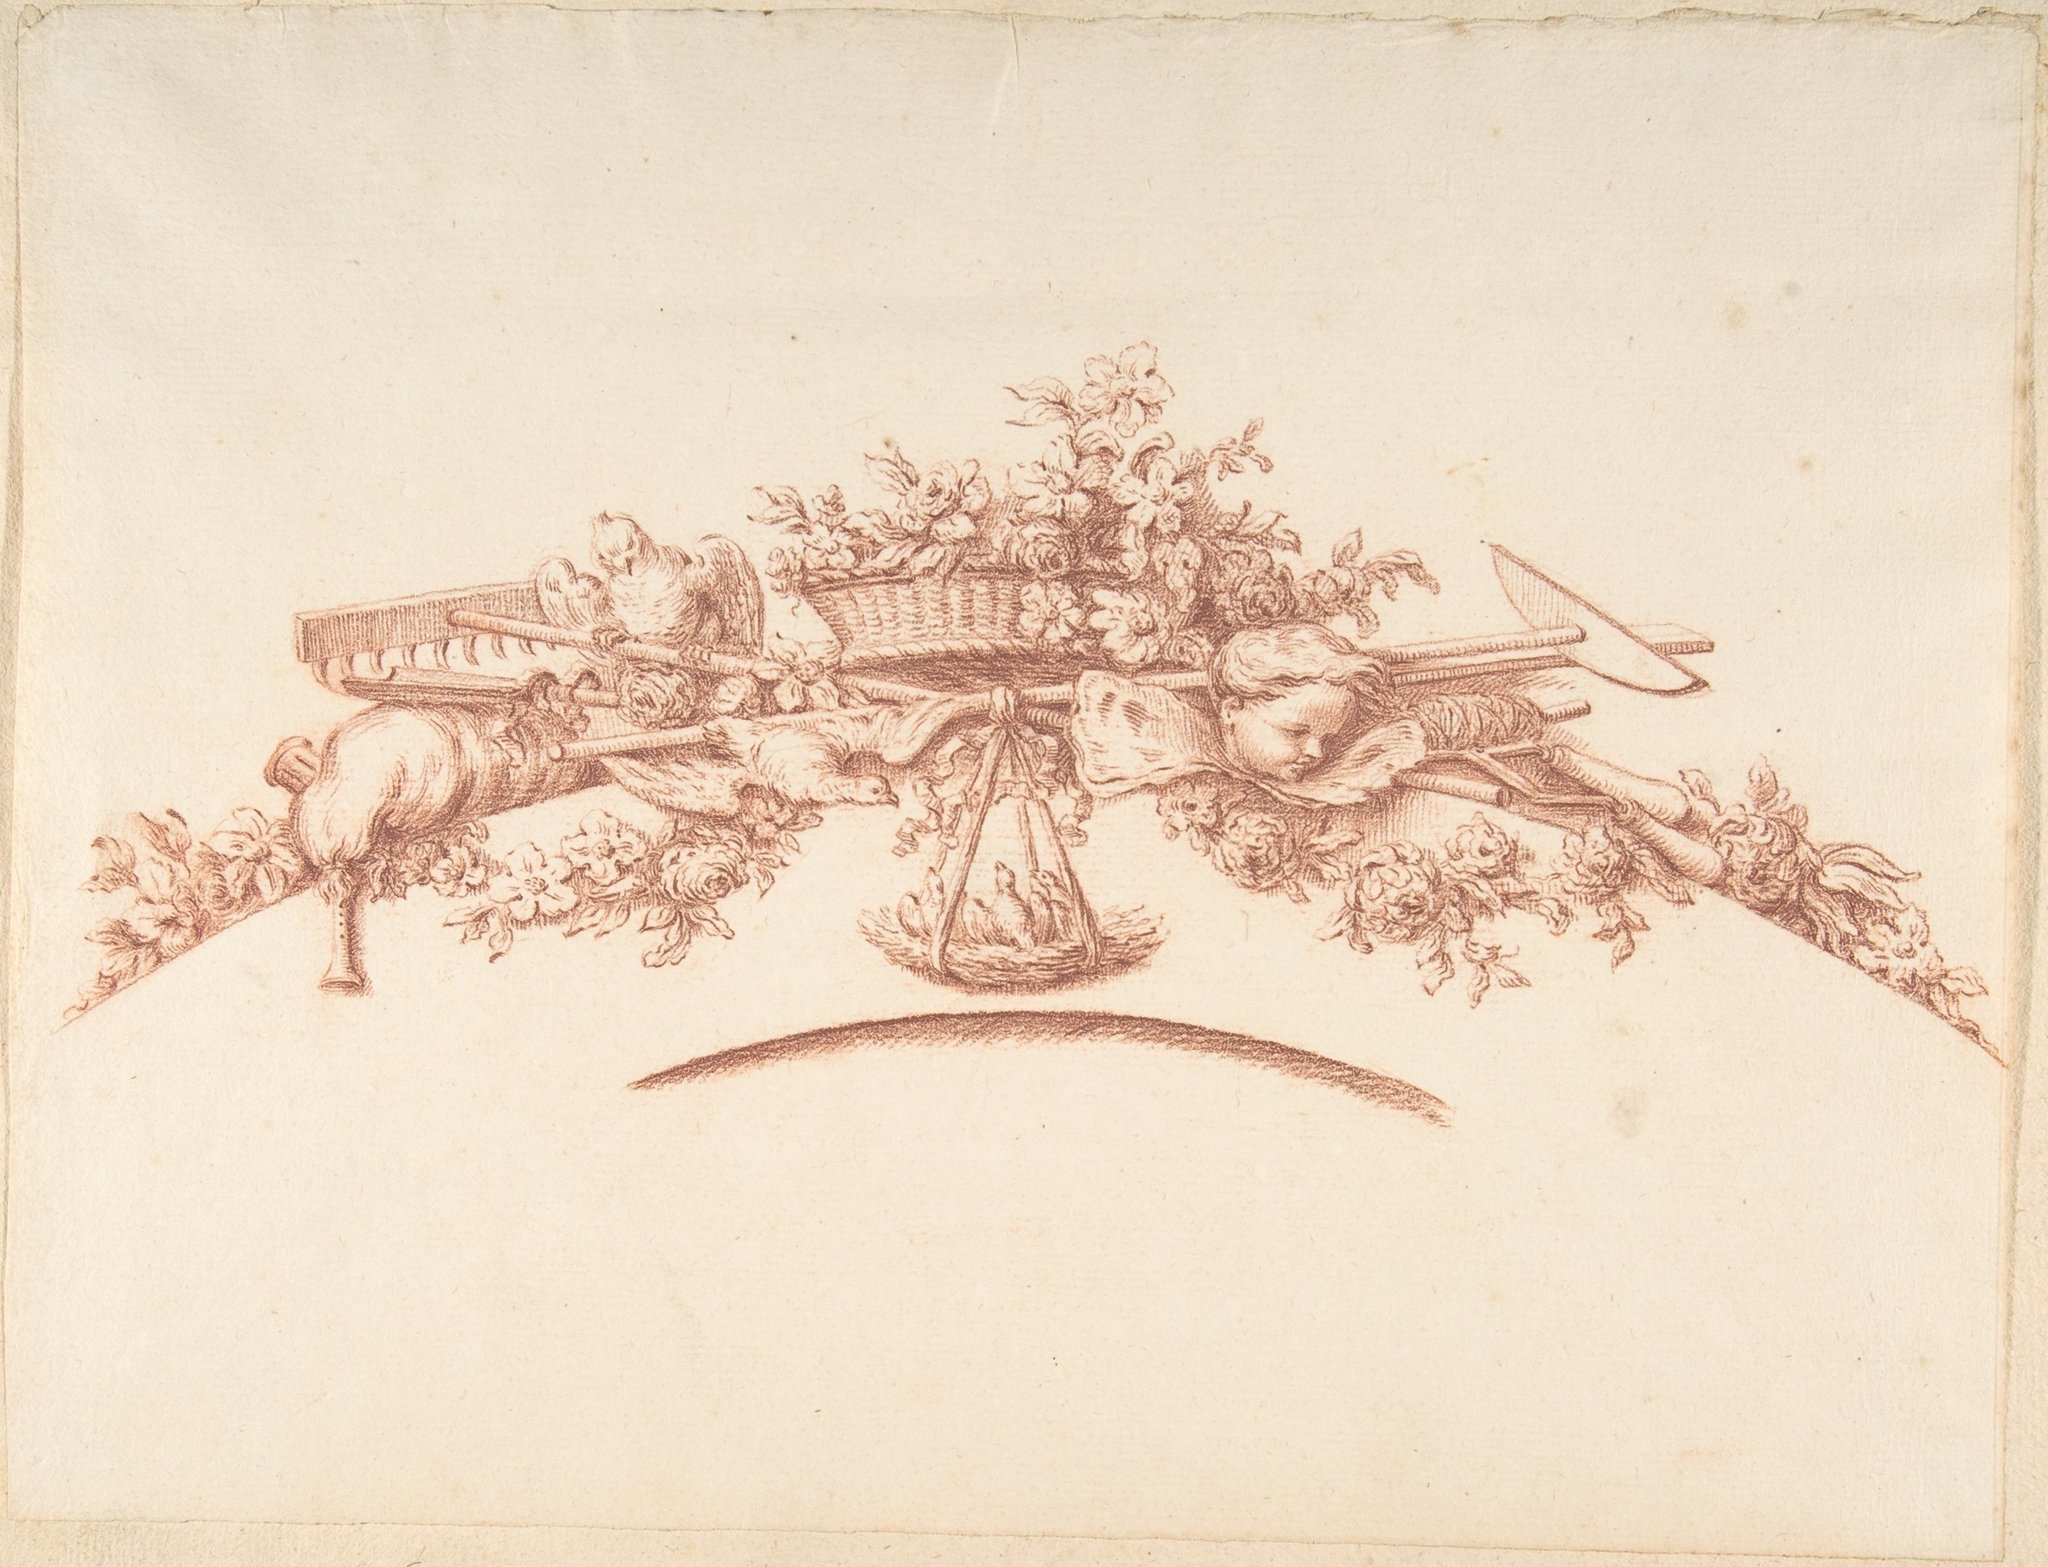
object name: drawing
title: Preparatory Study for Plate 41 in "Maisons de plaisance," Vol. II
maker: jacques françois blondel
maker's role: artist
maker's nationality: french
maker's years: 1705-1774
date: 1701-1800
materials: chalk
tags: birds,flowers